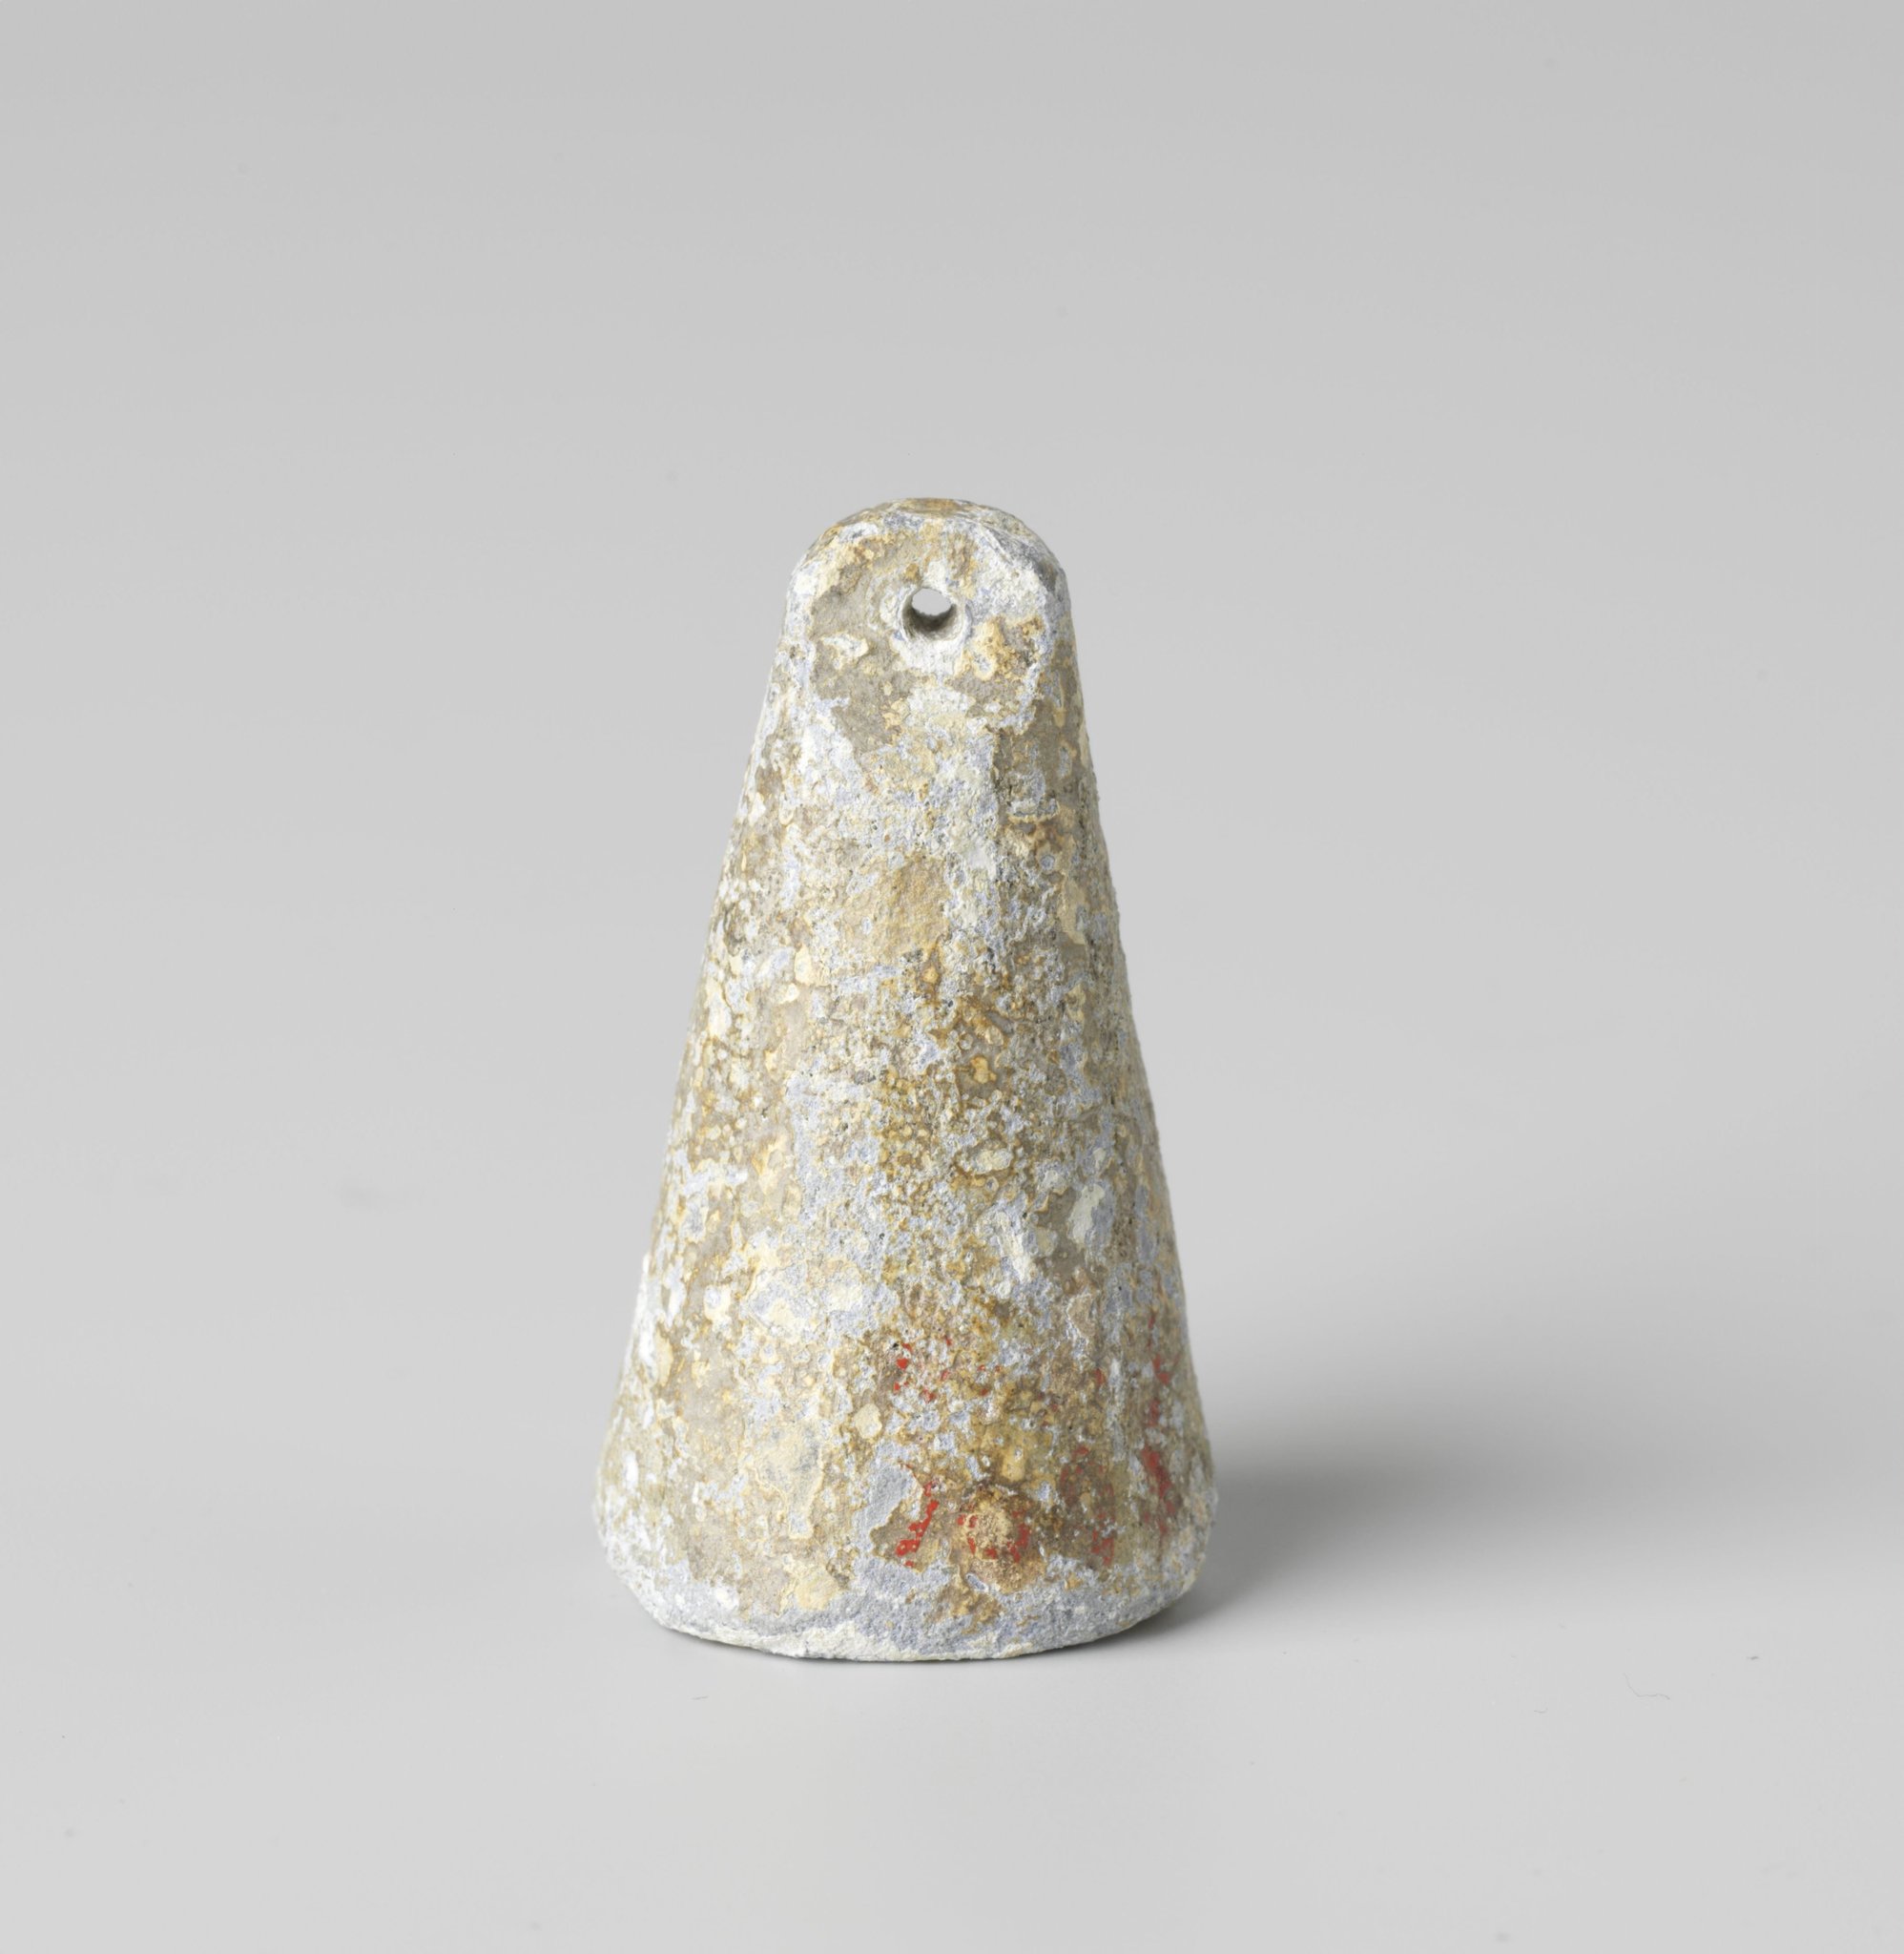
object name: loodje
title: Loodje, gewichtje of schietlood, kegelvormig met afgeplatte bovenzijde waarin een gaatje is aangebracht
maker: Anonymous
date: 1590-1596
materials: lead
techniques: casting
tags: willem barendsz., amsterdam, jacob van heemskerck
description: Loodje, gewichtje of schietlood, kegelvormig met een afgeplatte bovenzijde waarin een gaatje is aangebracht en aan de onderzijde een holte of ziel. Het loodje kan bevestigd worden aan een dun koord. Mogelijk is dit loodje een onderdeel van een nautisch instrument (een kwadrant) geweest.